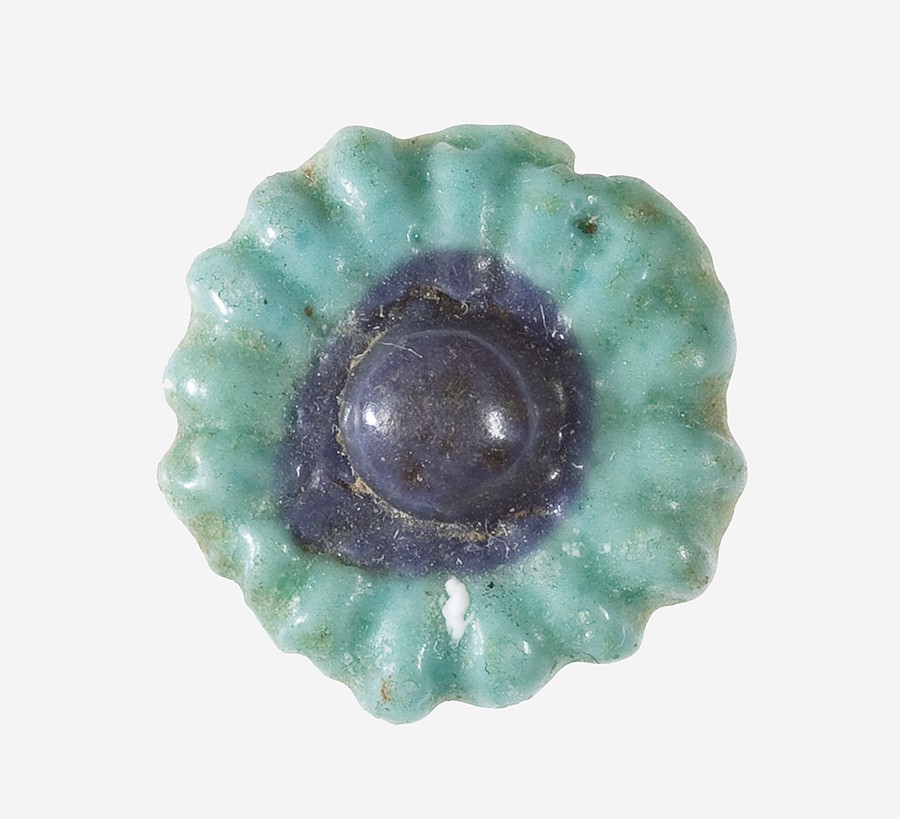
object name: pendant, daisy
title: Daisy Pendant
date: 1390-1352 BCE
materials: faience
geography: egypt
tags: daisies